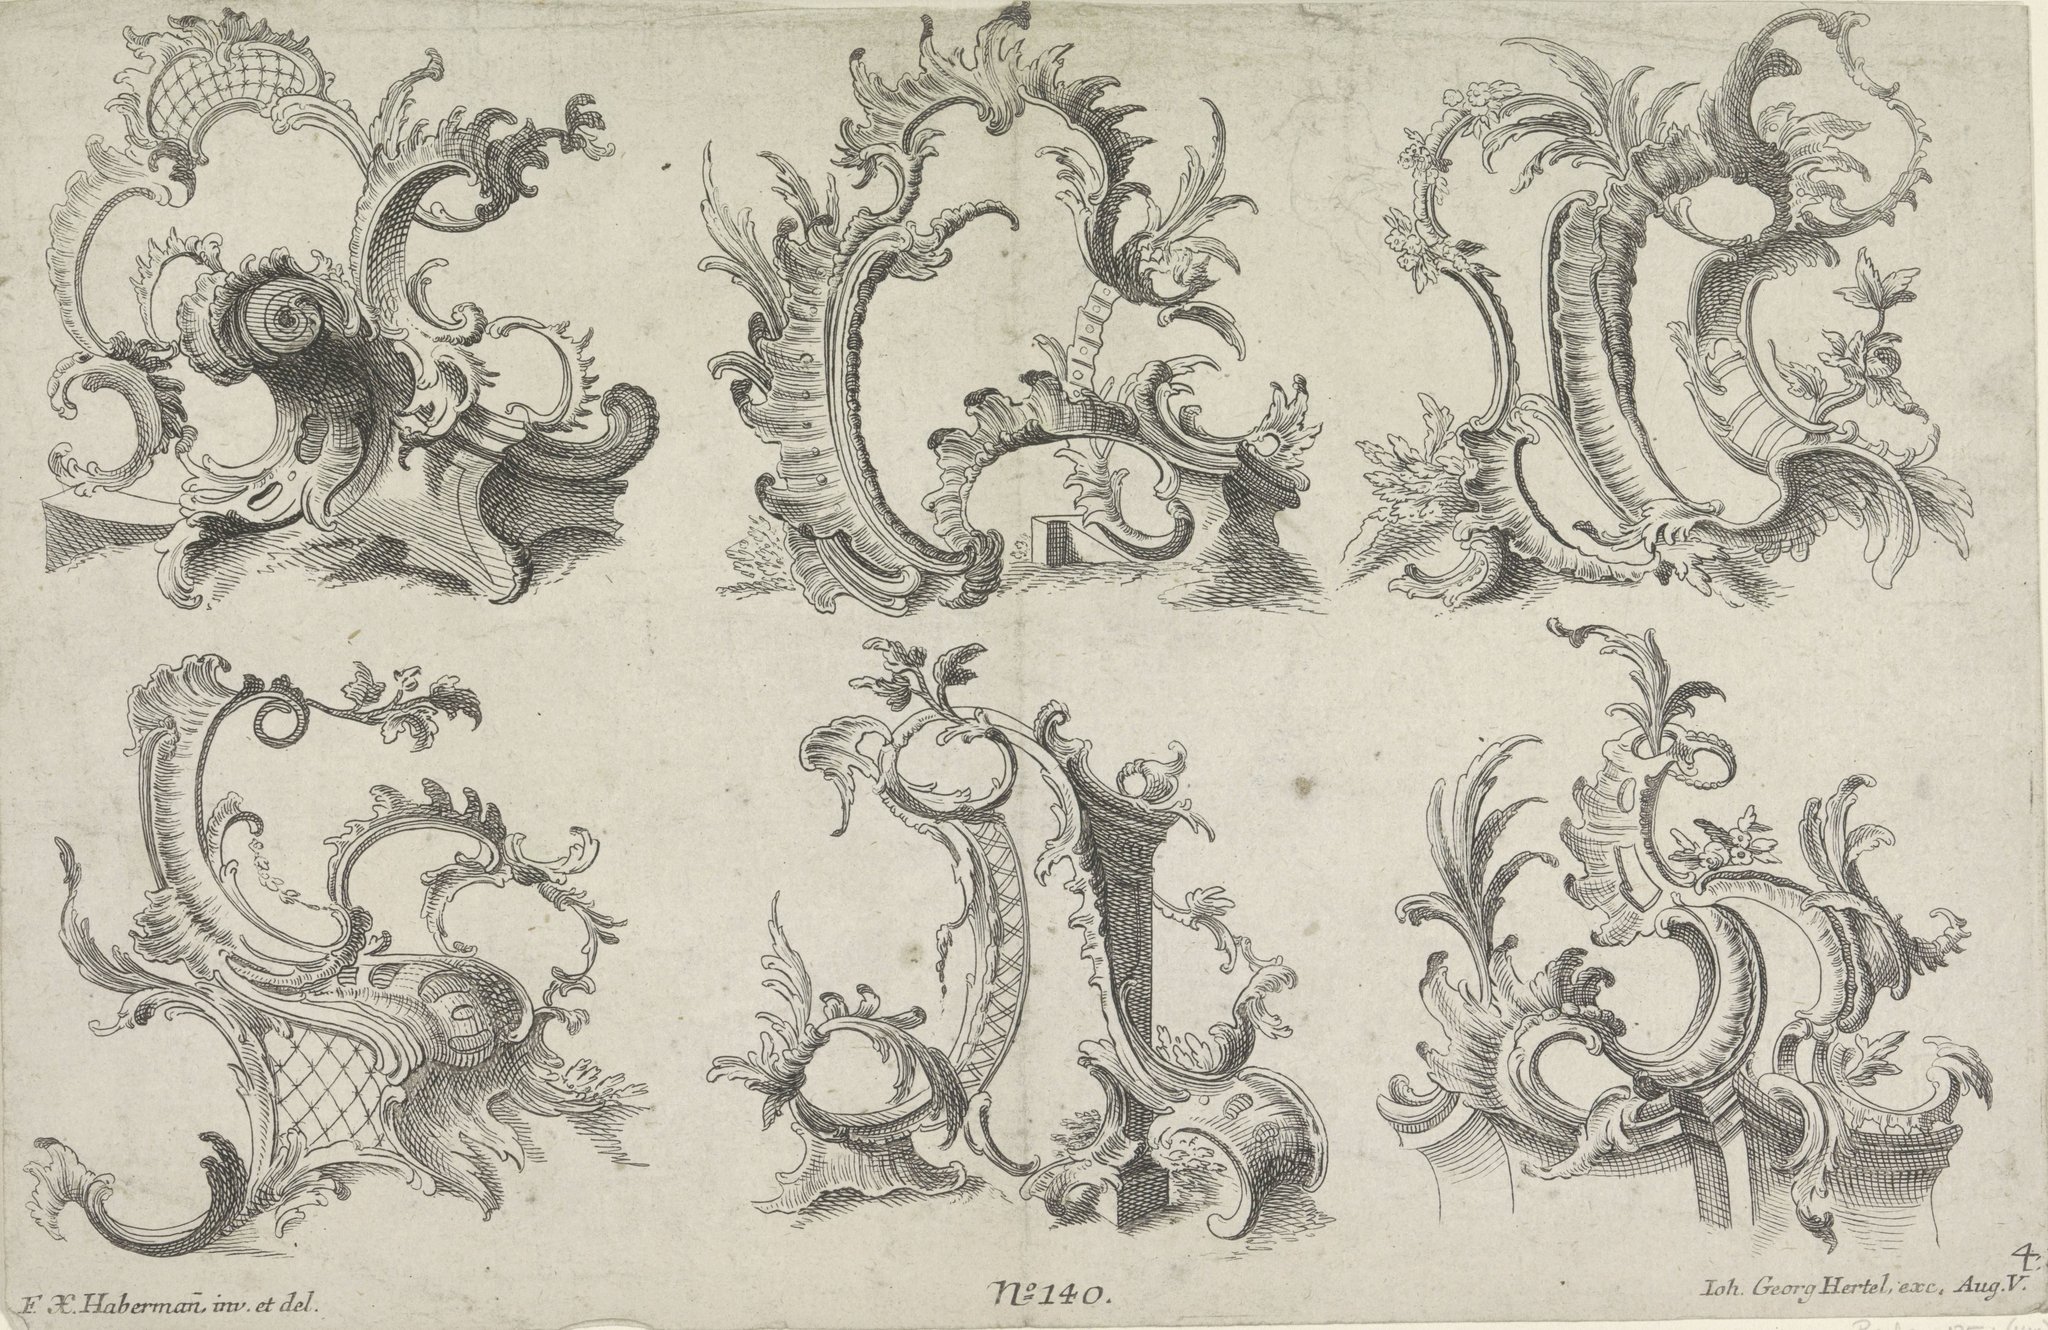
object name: print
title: Rocailles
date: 1731-1775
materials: paper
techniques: etching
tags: rocaille ornament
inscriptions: collector's mark: Lugt 2760, collector's mark: Lugt 2228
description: Zes rocaille ornamenten. Uitgeversnummer 140.